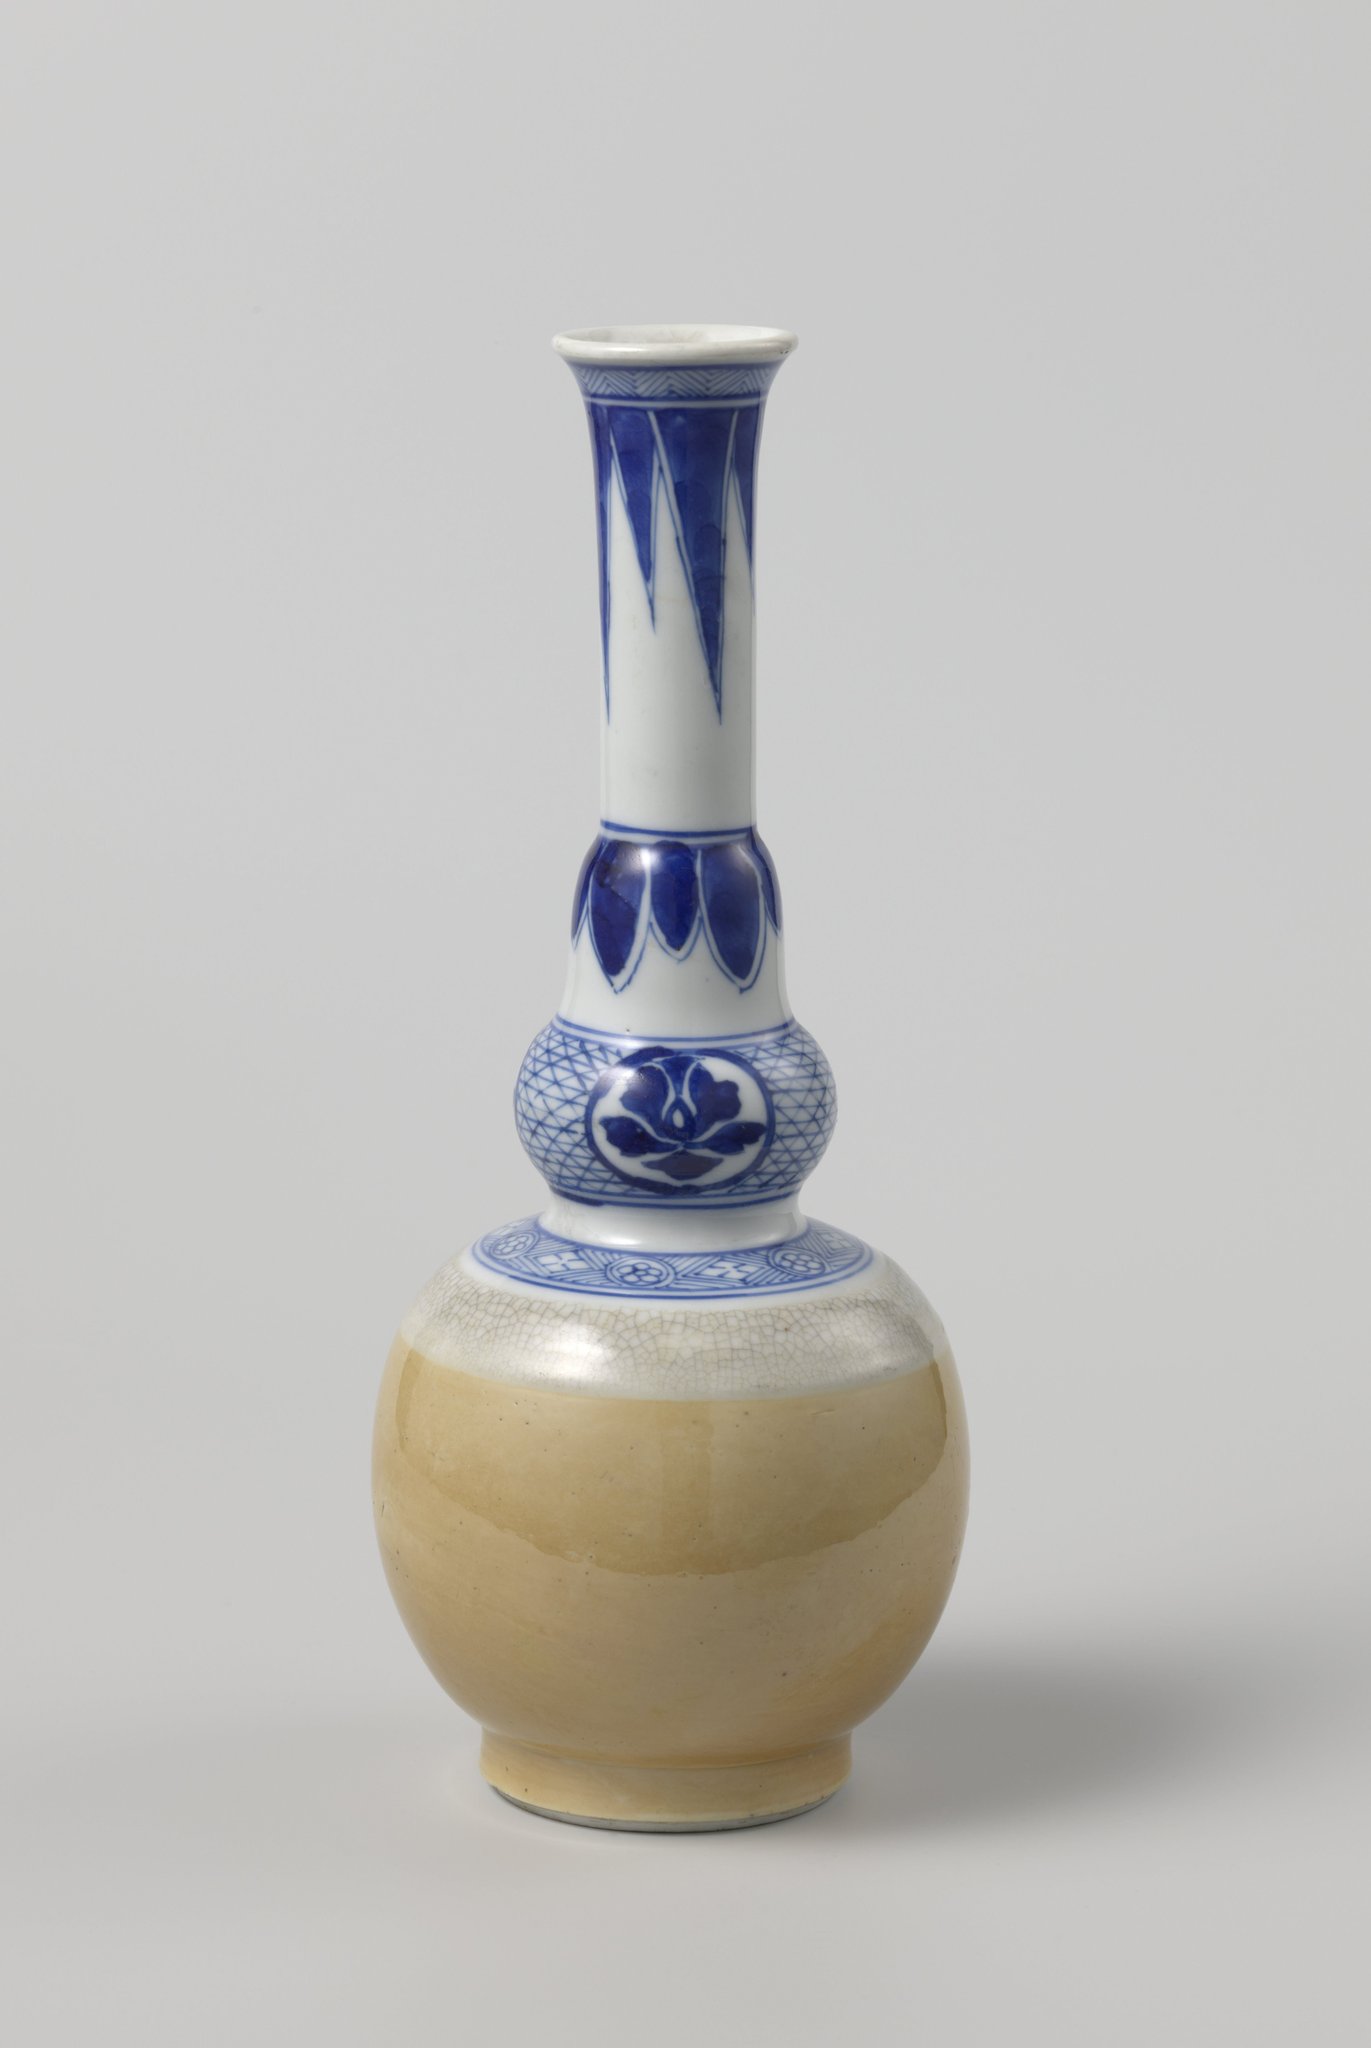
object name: sprinkler flask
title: Bottle vase with light brown and ornamental borders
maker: Anonymous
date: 1700-1724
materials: cobalt, glaze, paint, porcelain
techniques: firing, turning, vitrification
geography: china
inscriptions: label: ‘A. Staal Antiquaire/ Rokin 156 Amsterdam’